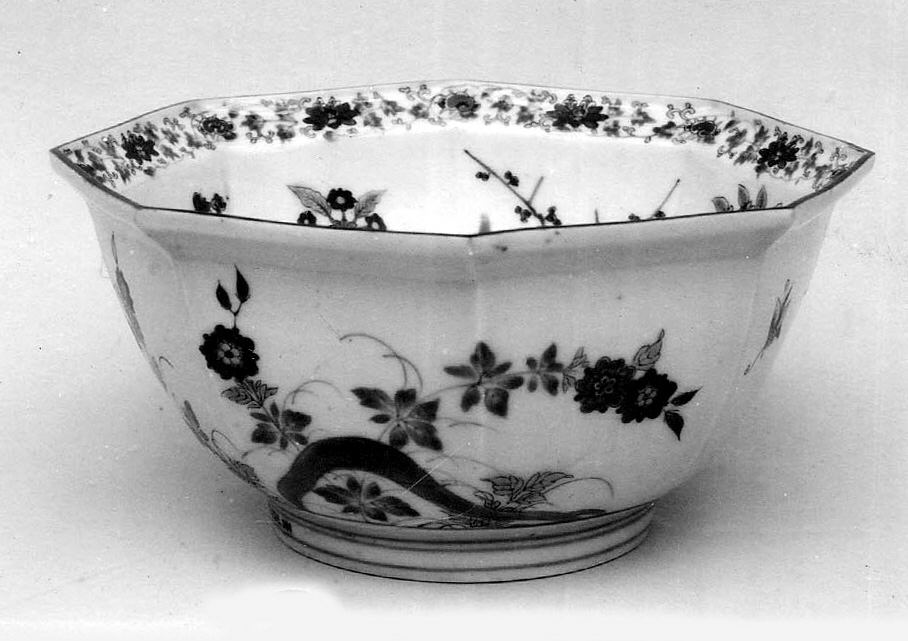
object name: bowl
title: Hexagonal Bowl with Decoration of Flowers of Four Seasons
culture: japanese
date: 1680-1710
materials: cobalt, enamel, gold, porcelain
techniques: underglaze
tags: flowers